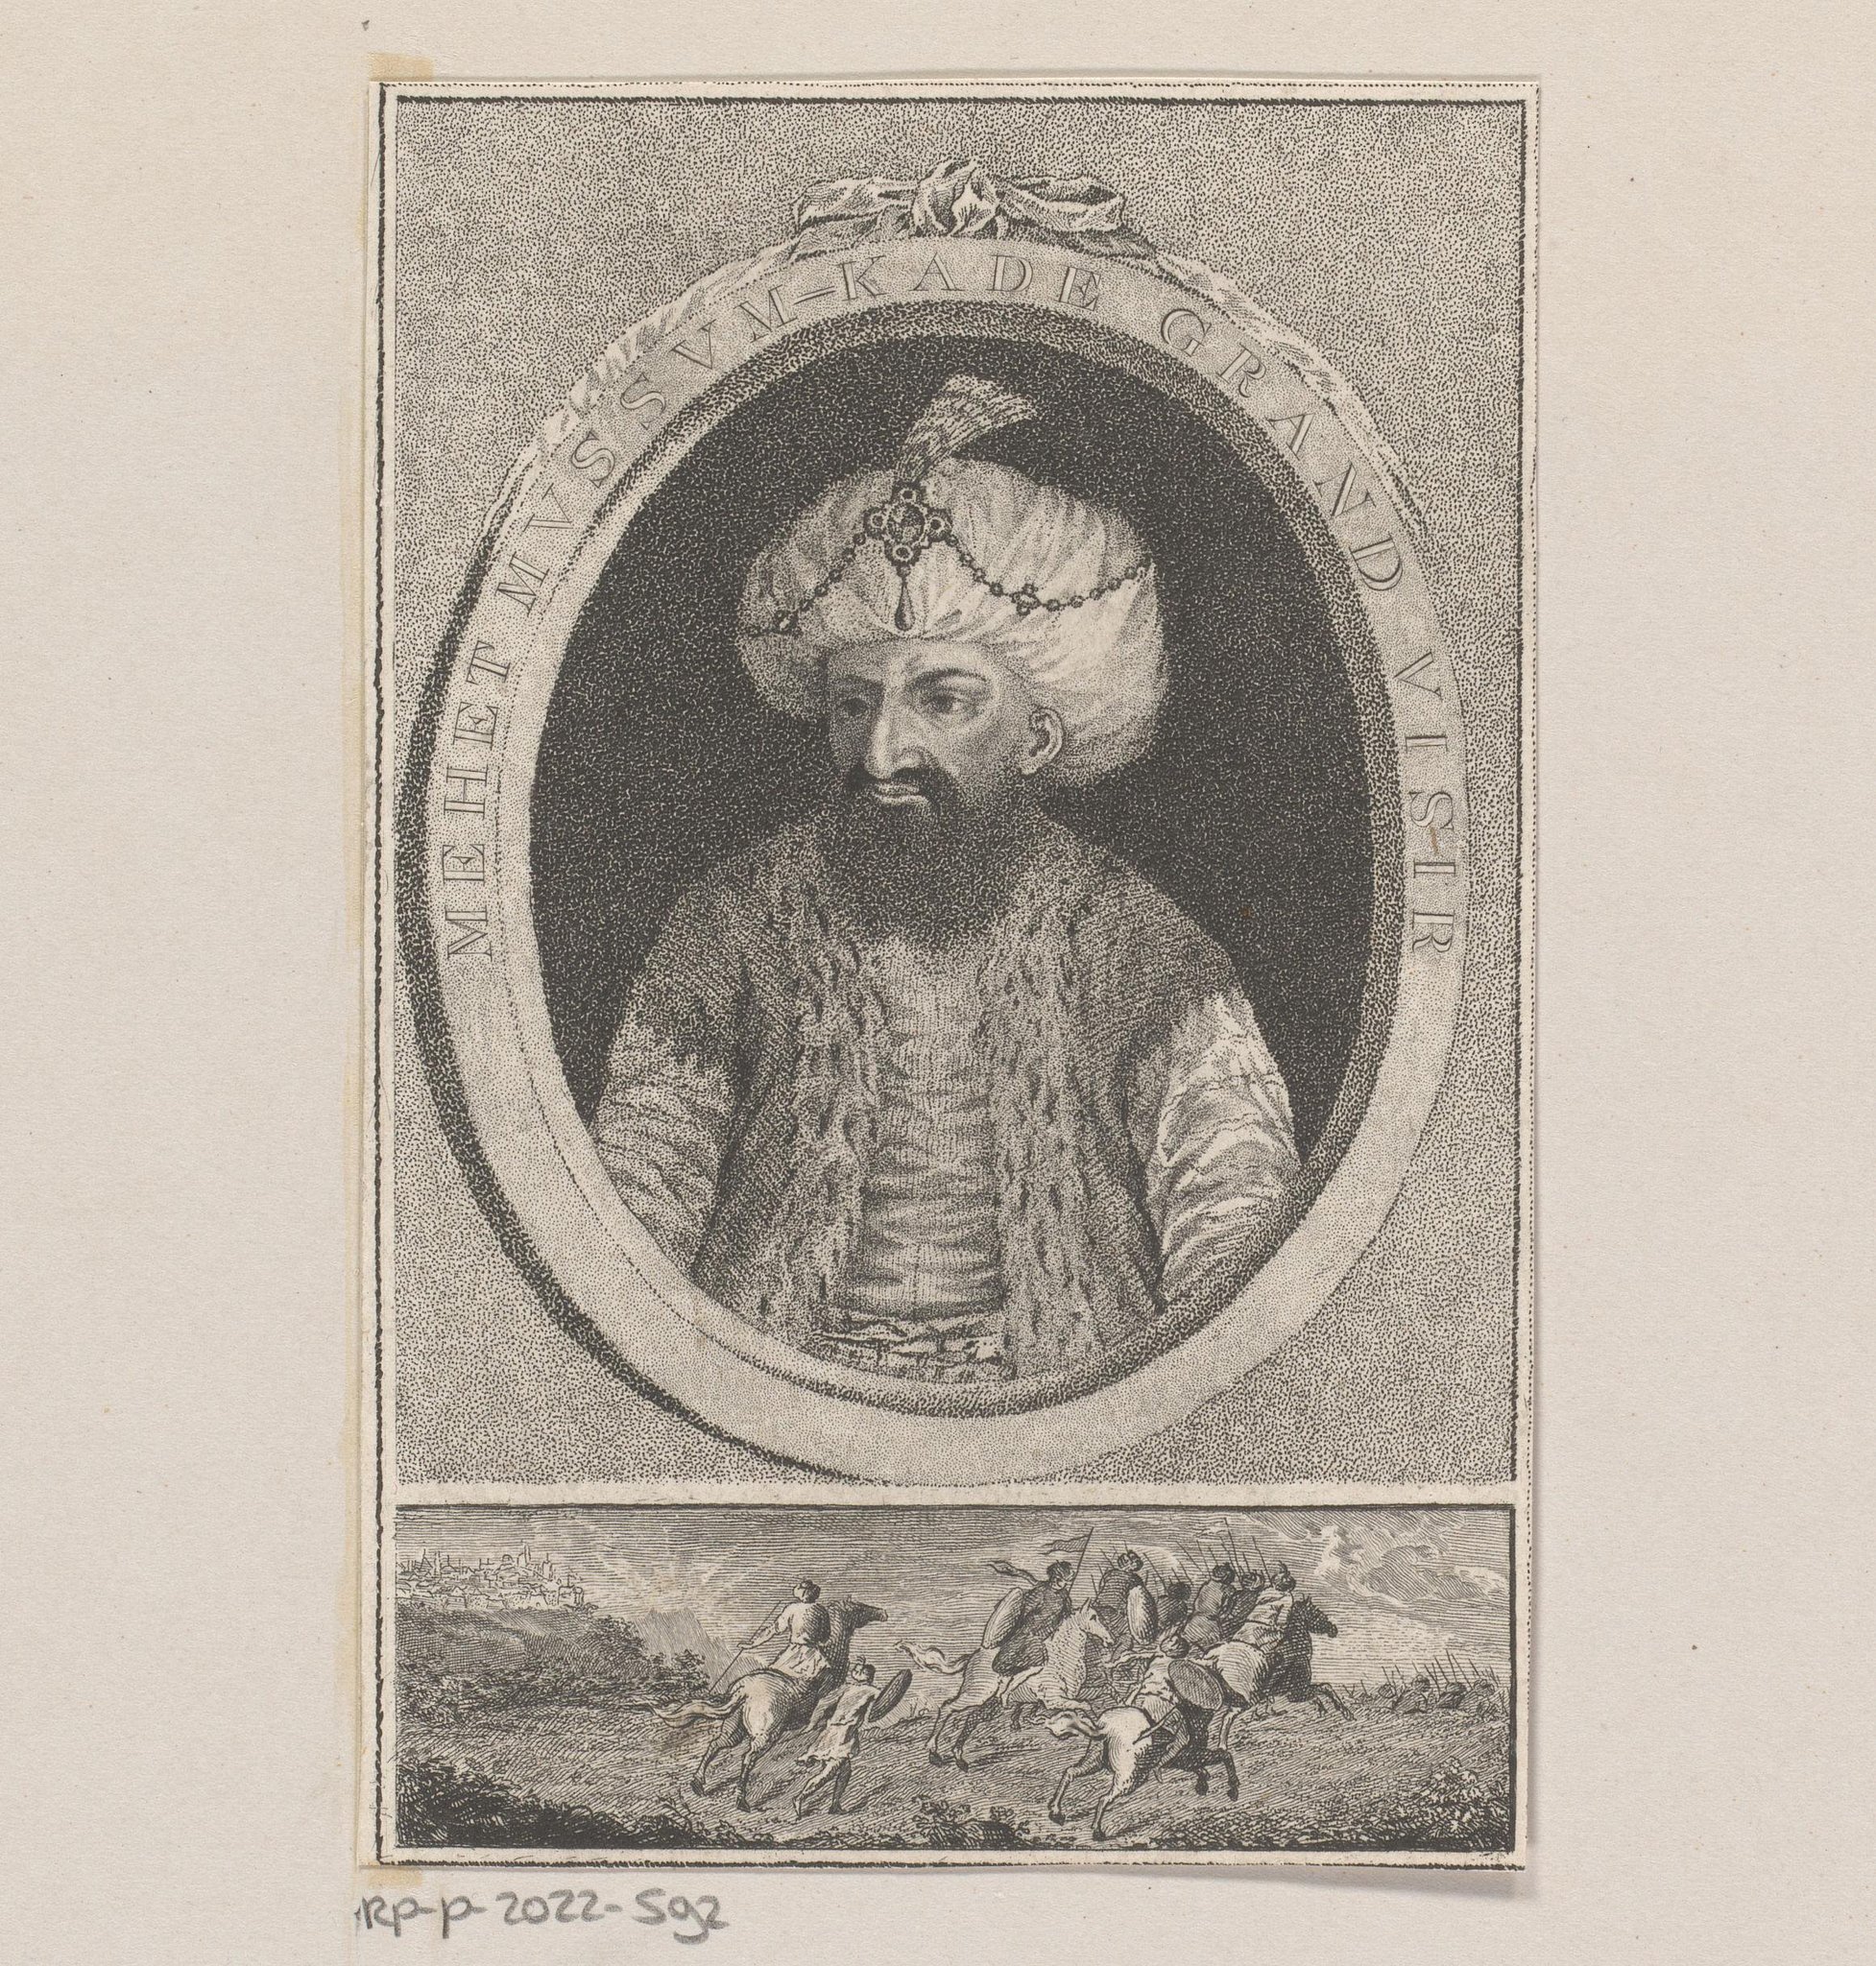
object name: print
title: Mehet Mussum-Kade Grand Visir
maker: Anonymous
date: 1650-1800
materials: paper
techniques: etching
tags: historical persons